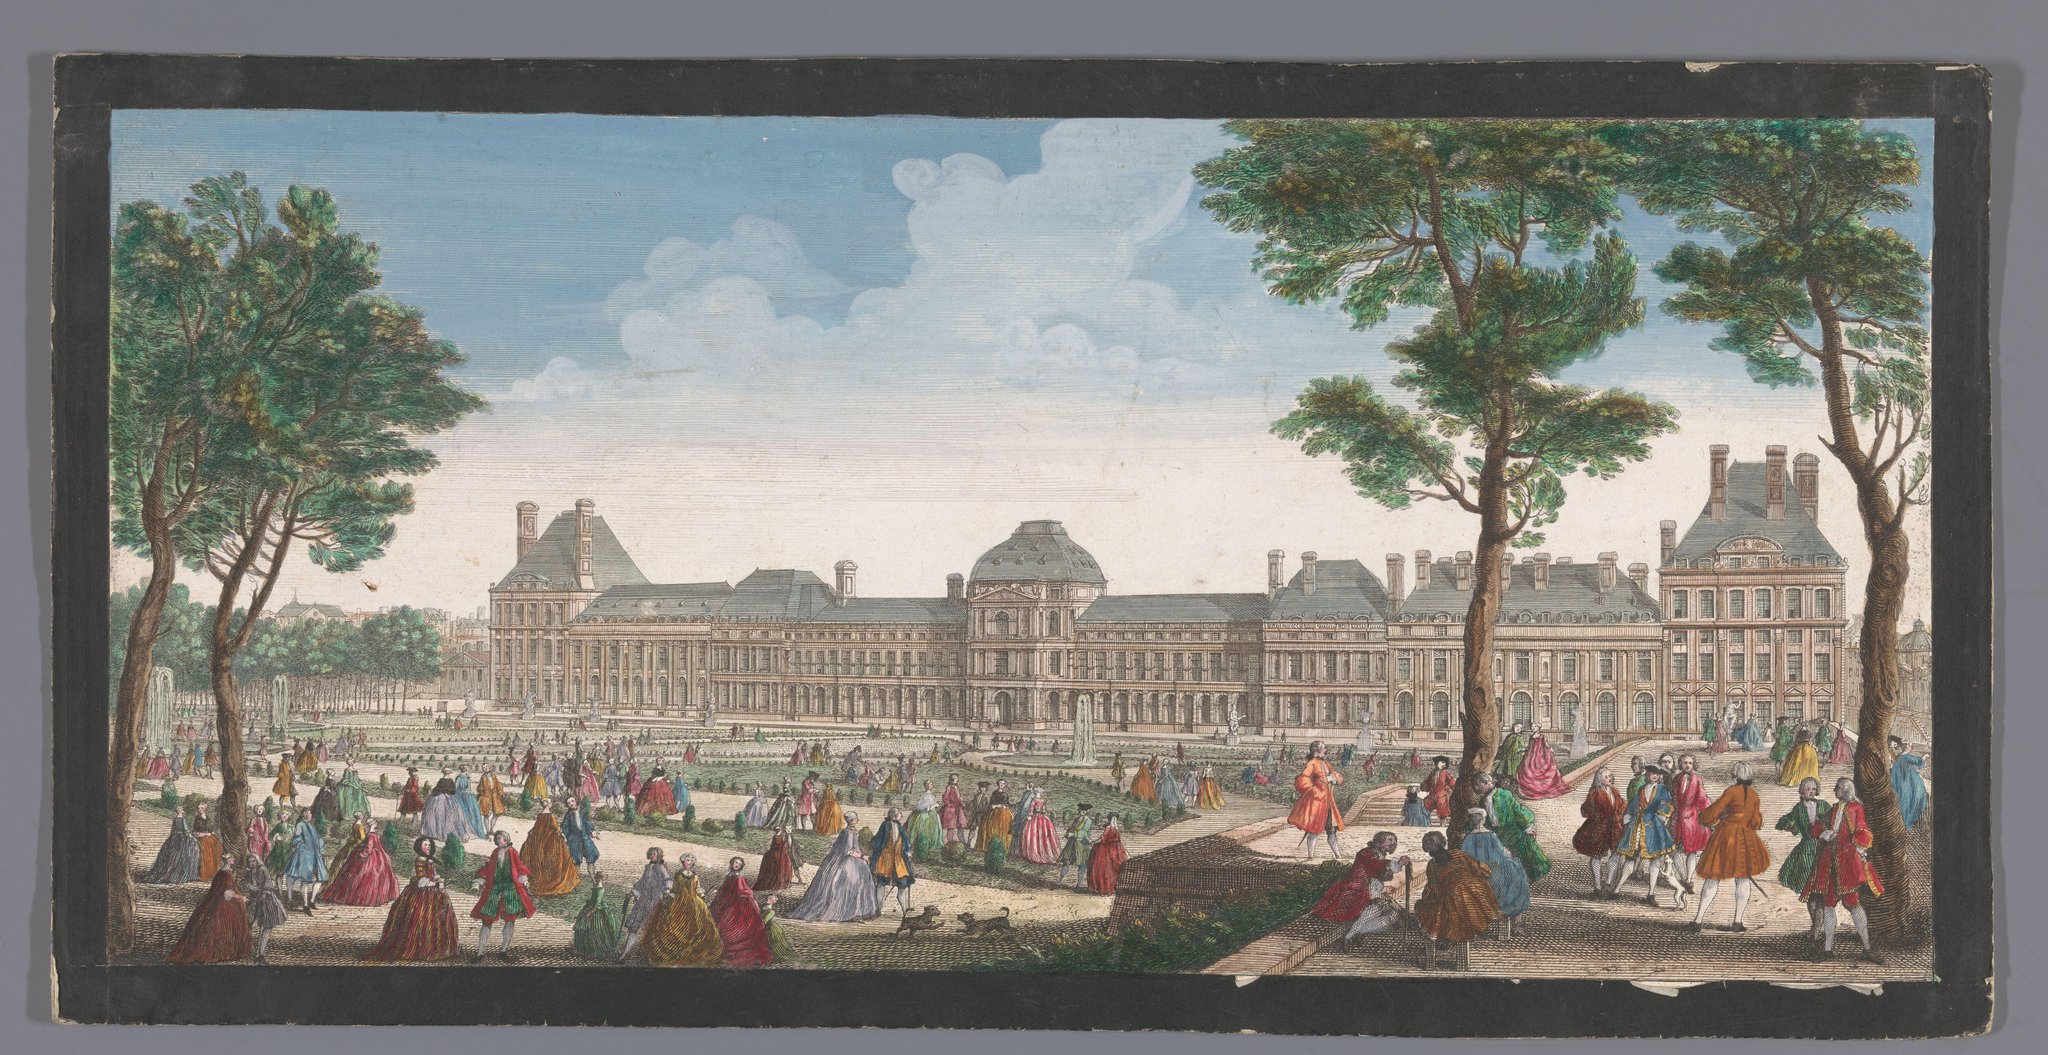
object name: print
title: Les promenades du Palais Thuilleries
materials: cardboard, paper, watercolor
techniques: brush, etching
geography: paris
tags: garden, garden fountain, ornamental plants, palace, tuileries palace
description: In de tuin wandelen en zitten groepen figuren.